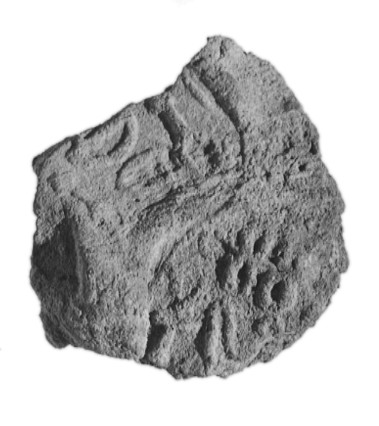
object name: sealing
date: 2030-1640 BCE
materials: clay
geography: egypt